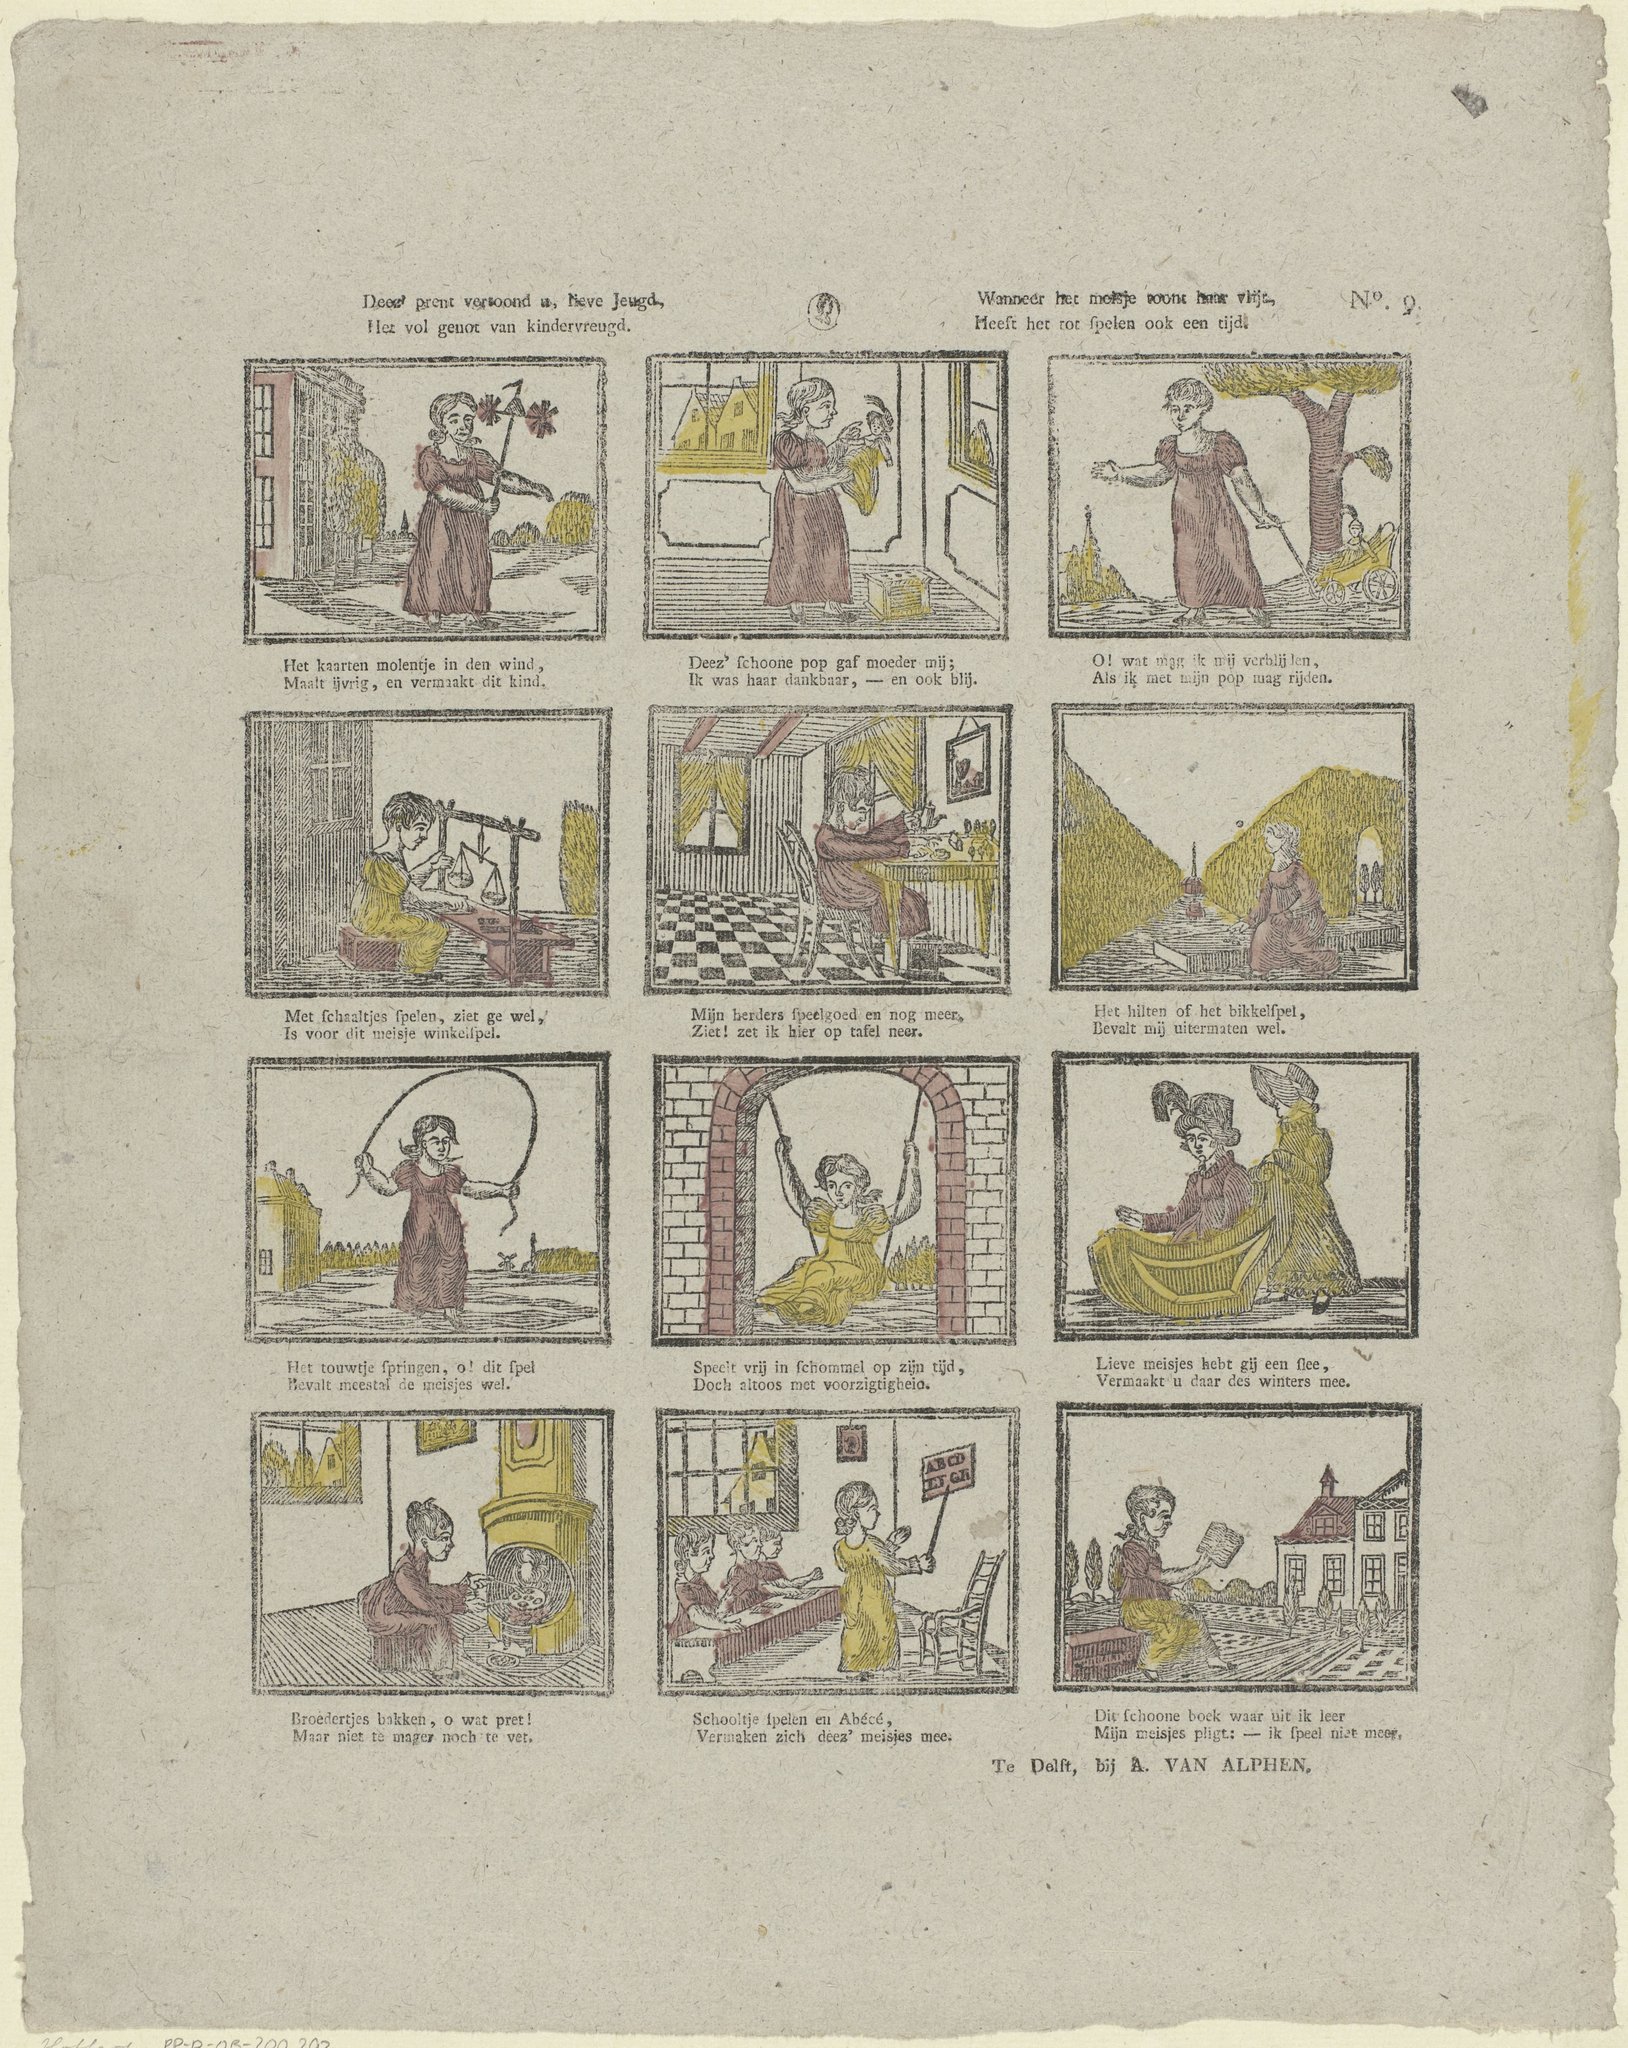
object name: print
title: Deez' prent vertoond u, lieve jeugd, / Het vol genot van kindervreugd. / Wanneer het meisje toont haar vlijt, / Heeft het tot spelen ook een tijd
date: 1820-1838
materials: paper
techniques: colour, letterpress printing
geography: rotterdam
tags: children's games and plays, (playing with) dolls, jumping-rope games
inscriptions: collector's mark: Lugt 2760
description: Blad met 16 voorstellingen spelende meisjes, waaronder spelen met poppen, touwtjespringen en schooltje spelen. Onder elke afbeelding een tweeregelig vers. Genummerd rechtsboven: No. 9.